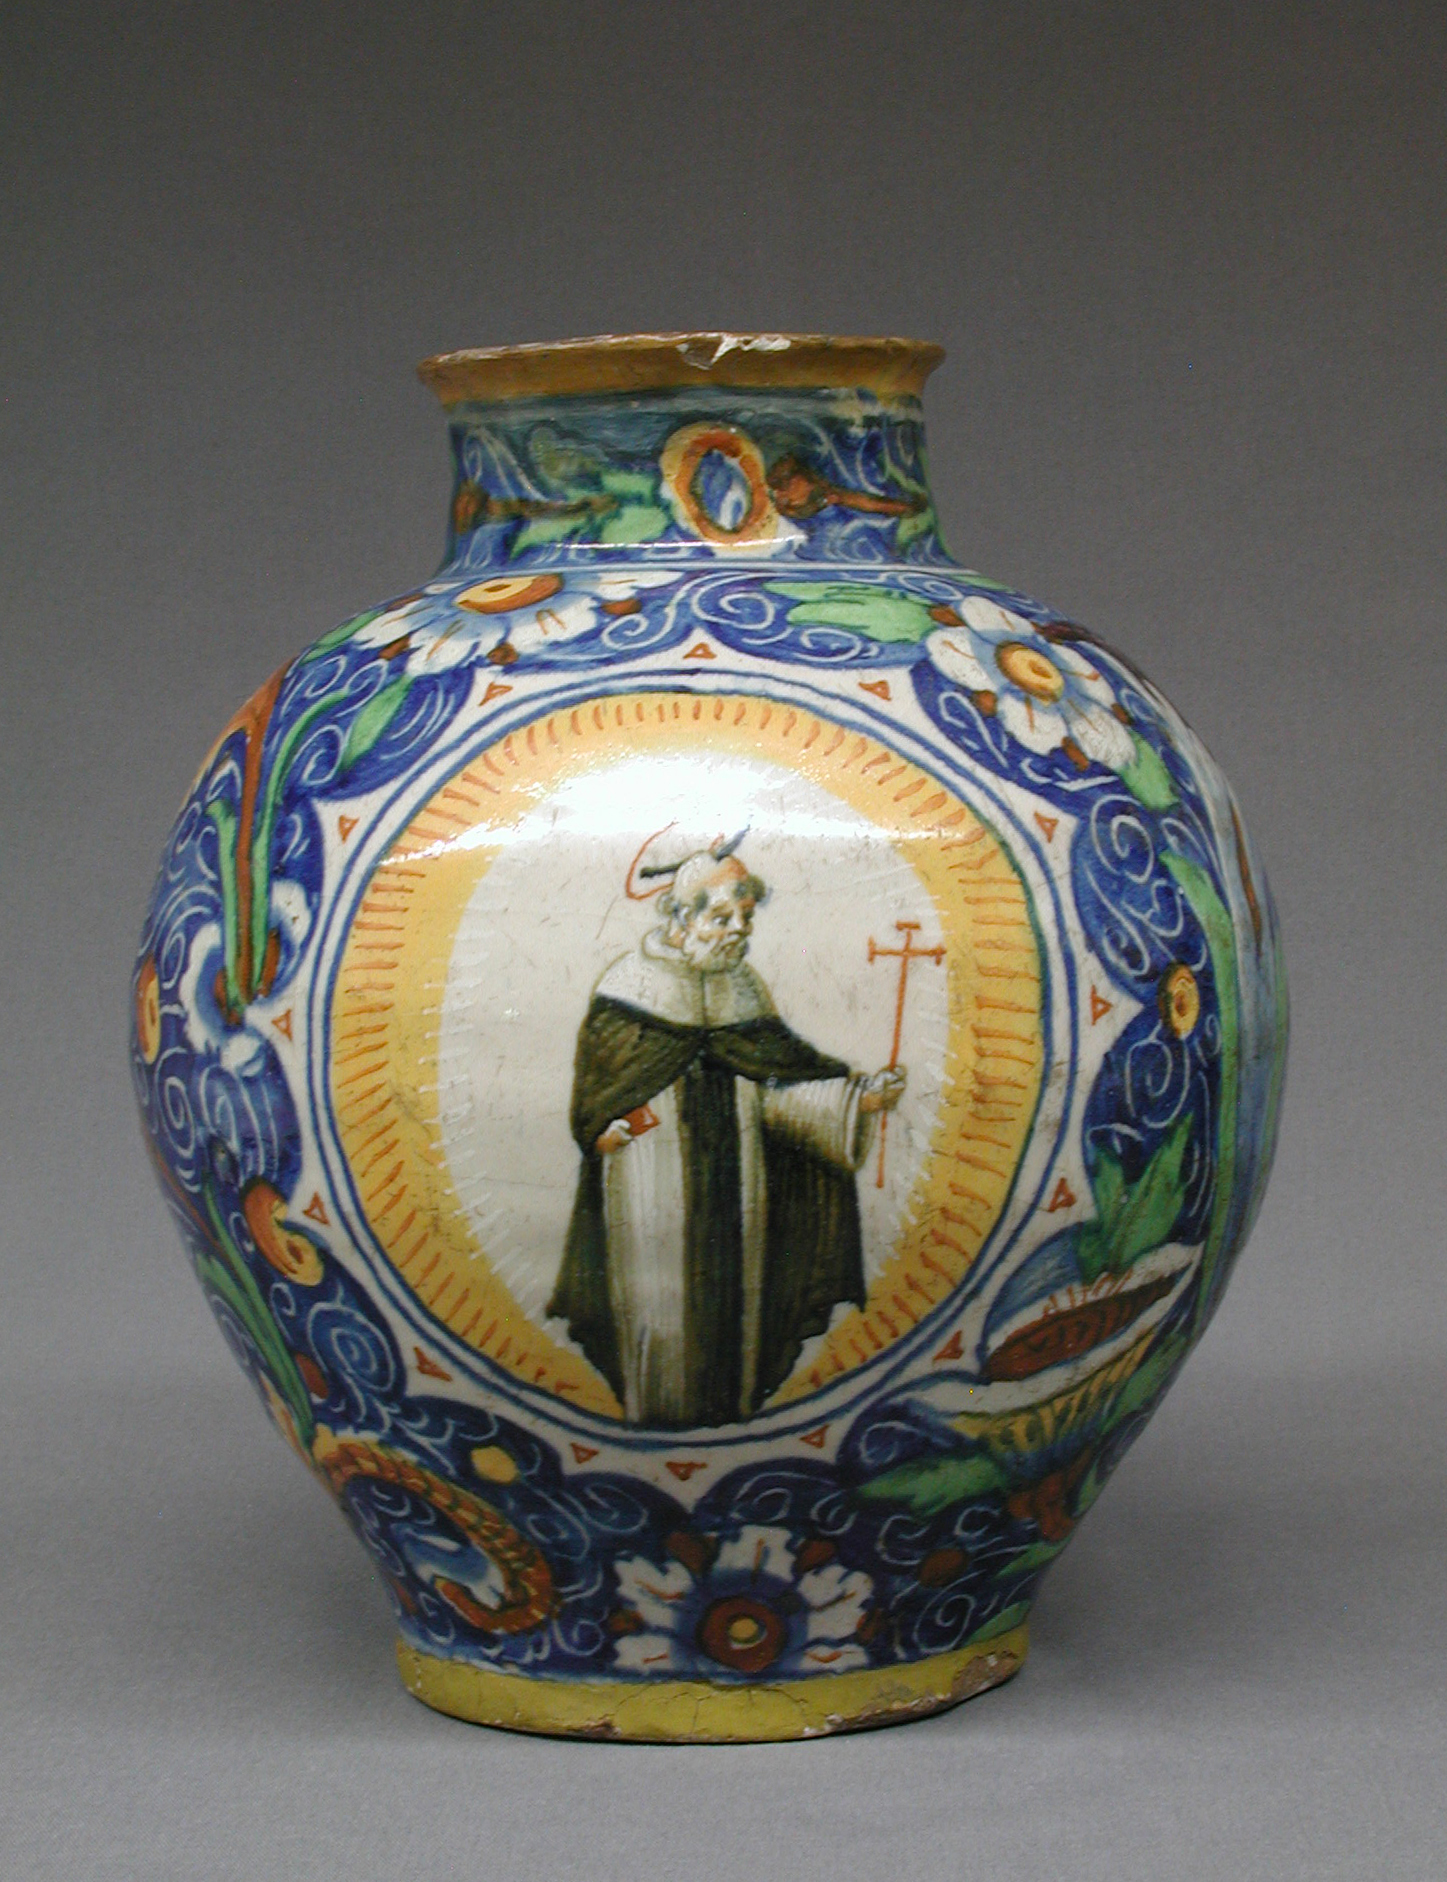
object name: jar, globular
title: Globular jar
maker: domenico veneziano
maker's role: maker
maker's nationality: italian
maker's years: 1438-1461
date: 1567-1600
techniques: maiolica, glazing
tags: cross